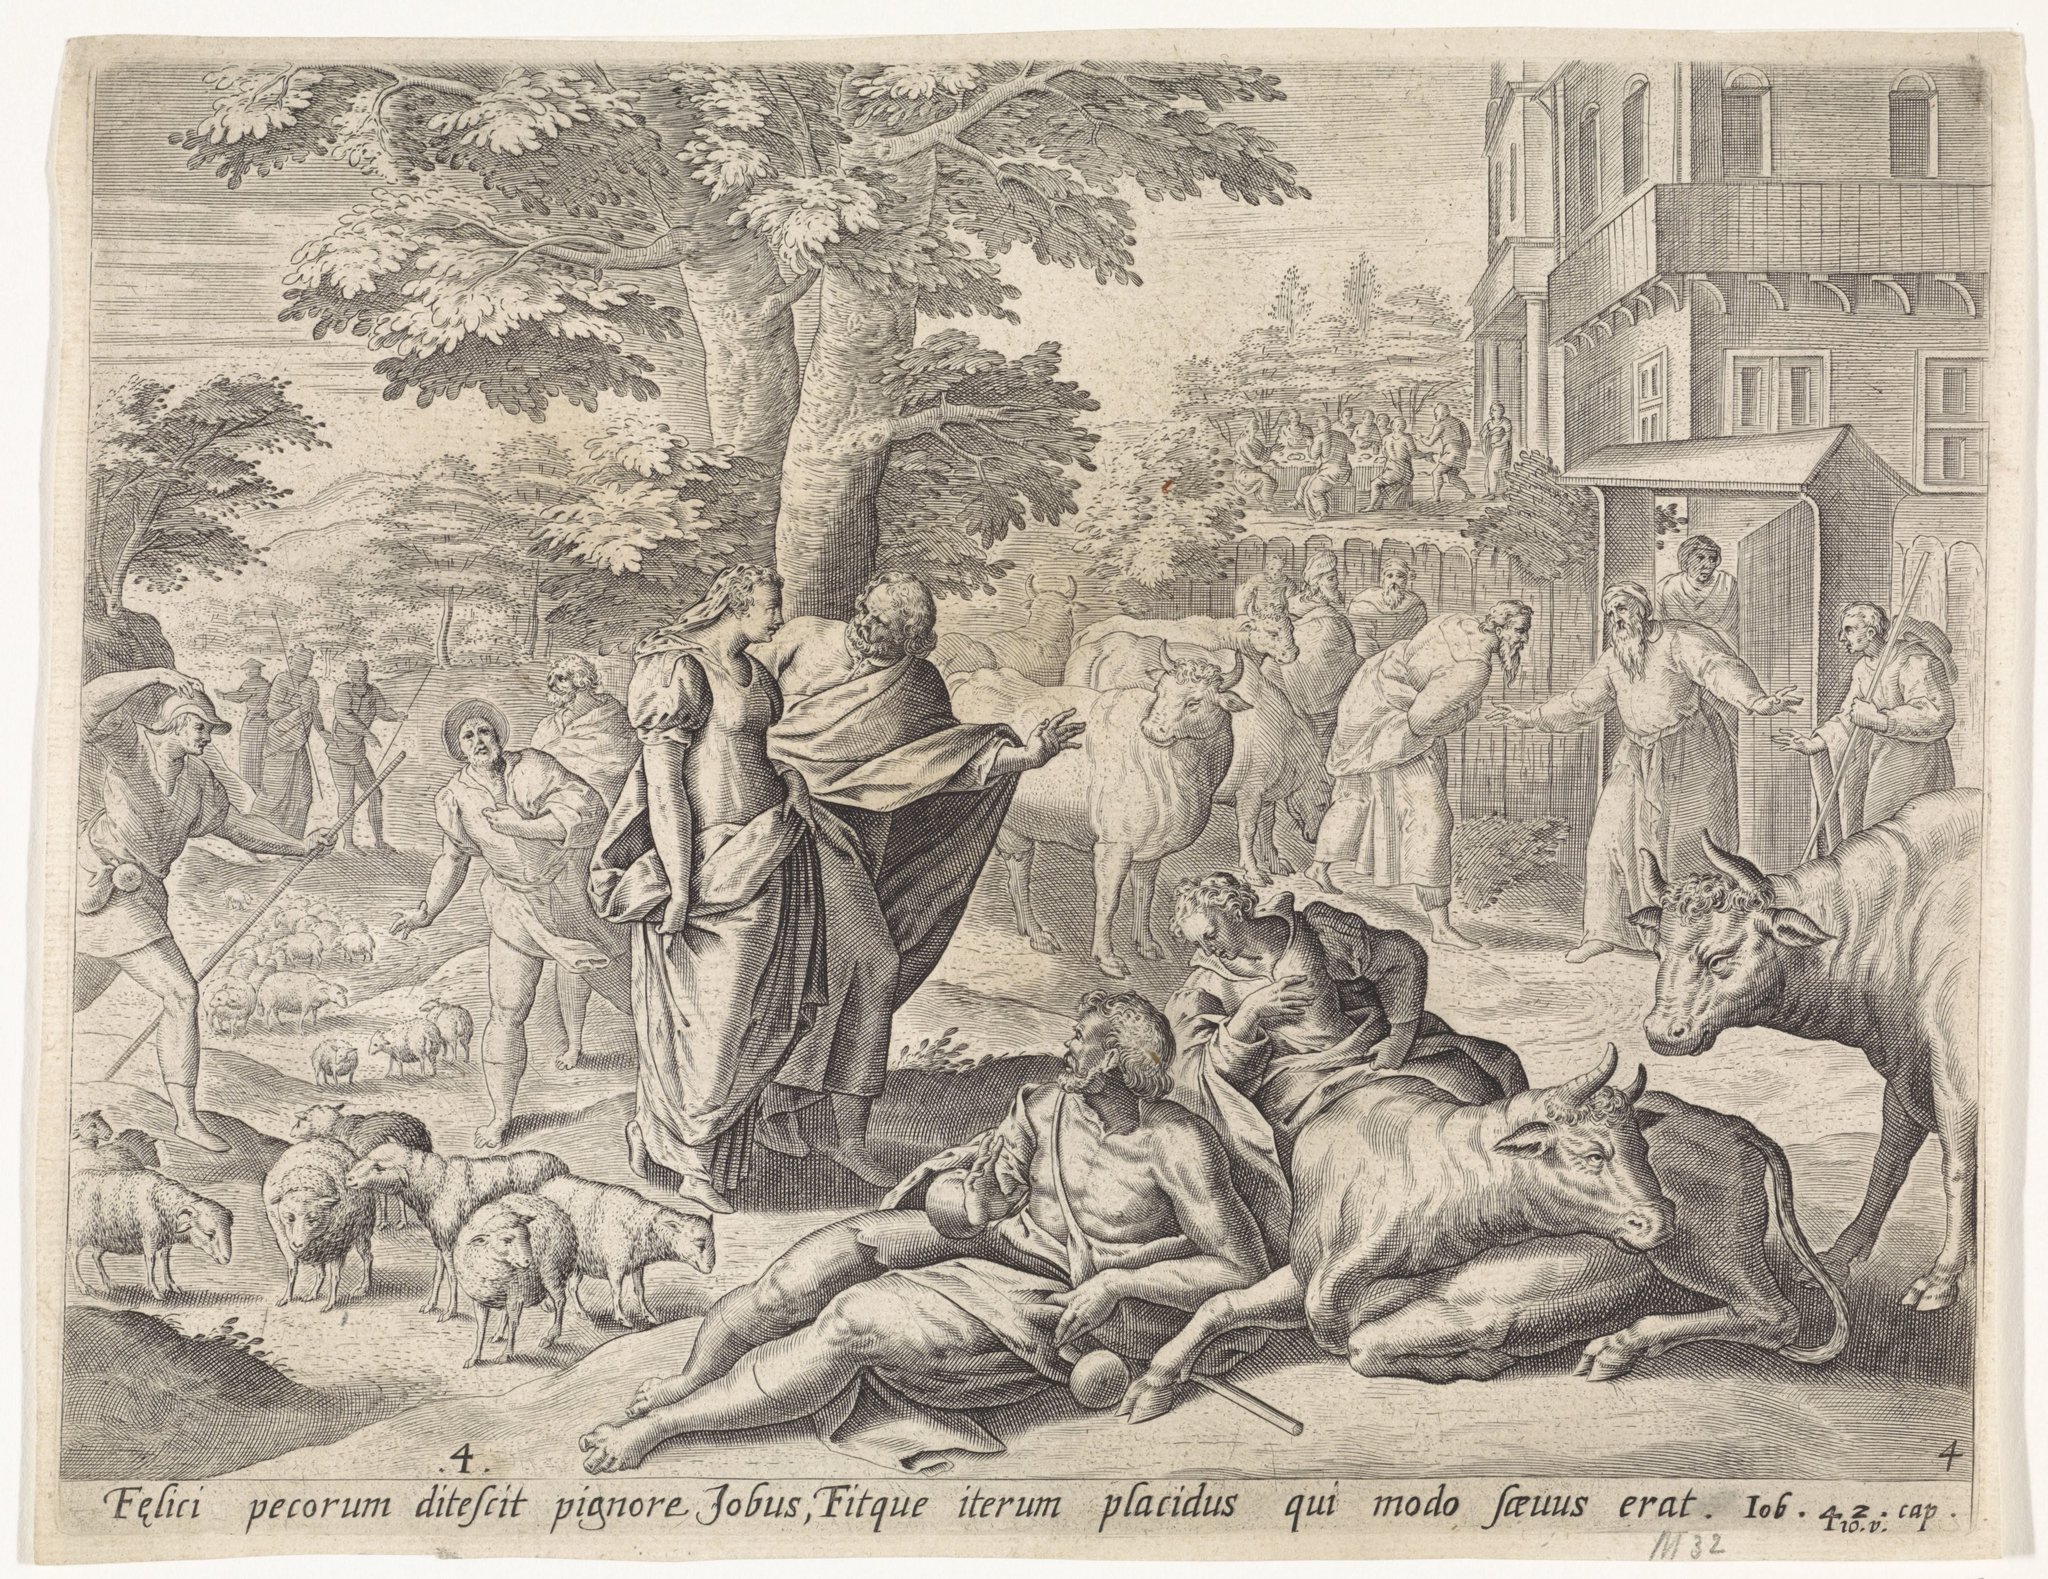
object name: print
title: Theatrum biblicum (...)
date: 1579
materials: paper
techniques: engraving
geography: amsterdam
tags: job's prosperity restored; the last part of his life (job 42:10-17)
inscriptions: collector's mark: Lugt 2228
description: Na alle ellende die Job is overkomen verdubbelen zijn bezittingen. Job ontvangt bij de poort van zijn huis zijn vrienden en overgebleven familieleden. Op de voorgrond staan zijn kinderen en zijn vee. Op de achtergrond wordt in de tuin een feest gegeven. Onder de voorstelling een verwijzing in het Latijn naar de Bijbeltekst in Job 42:10.